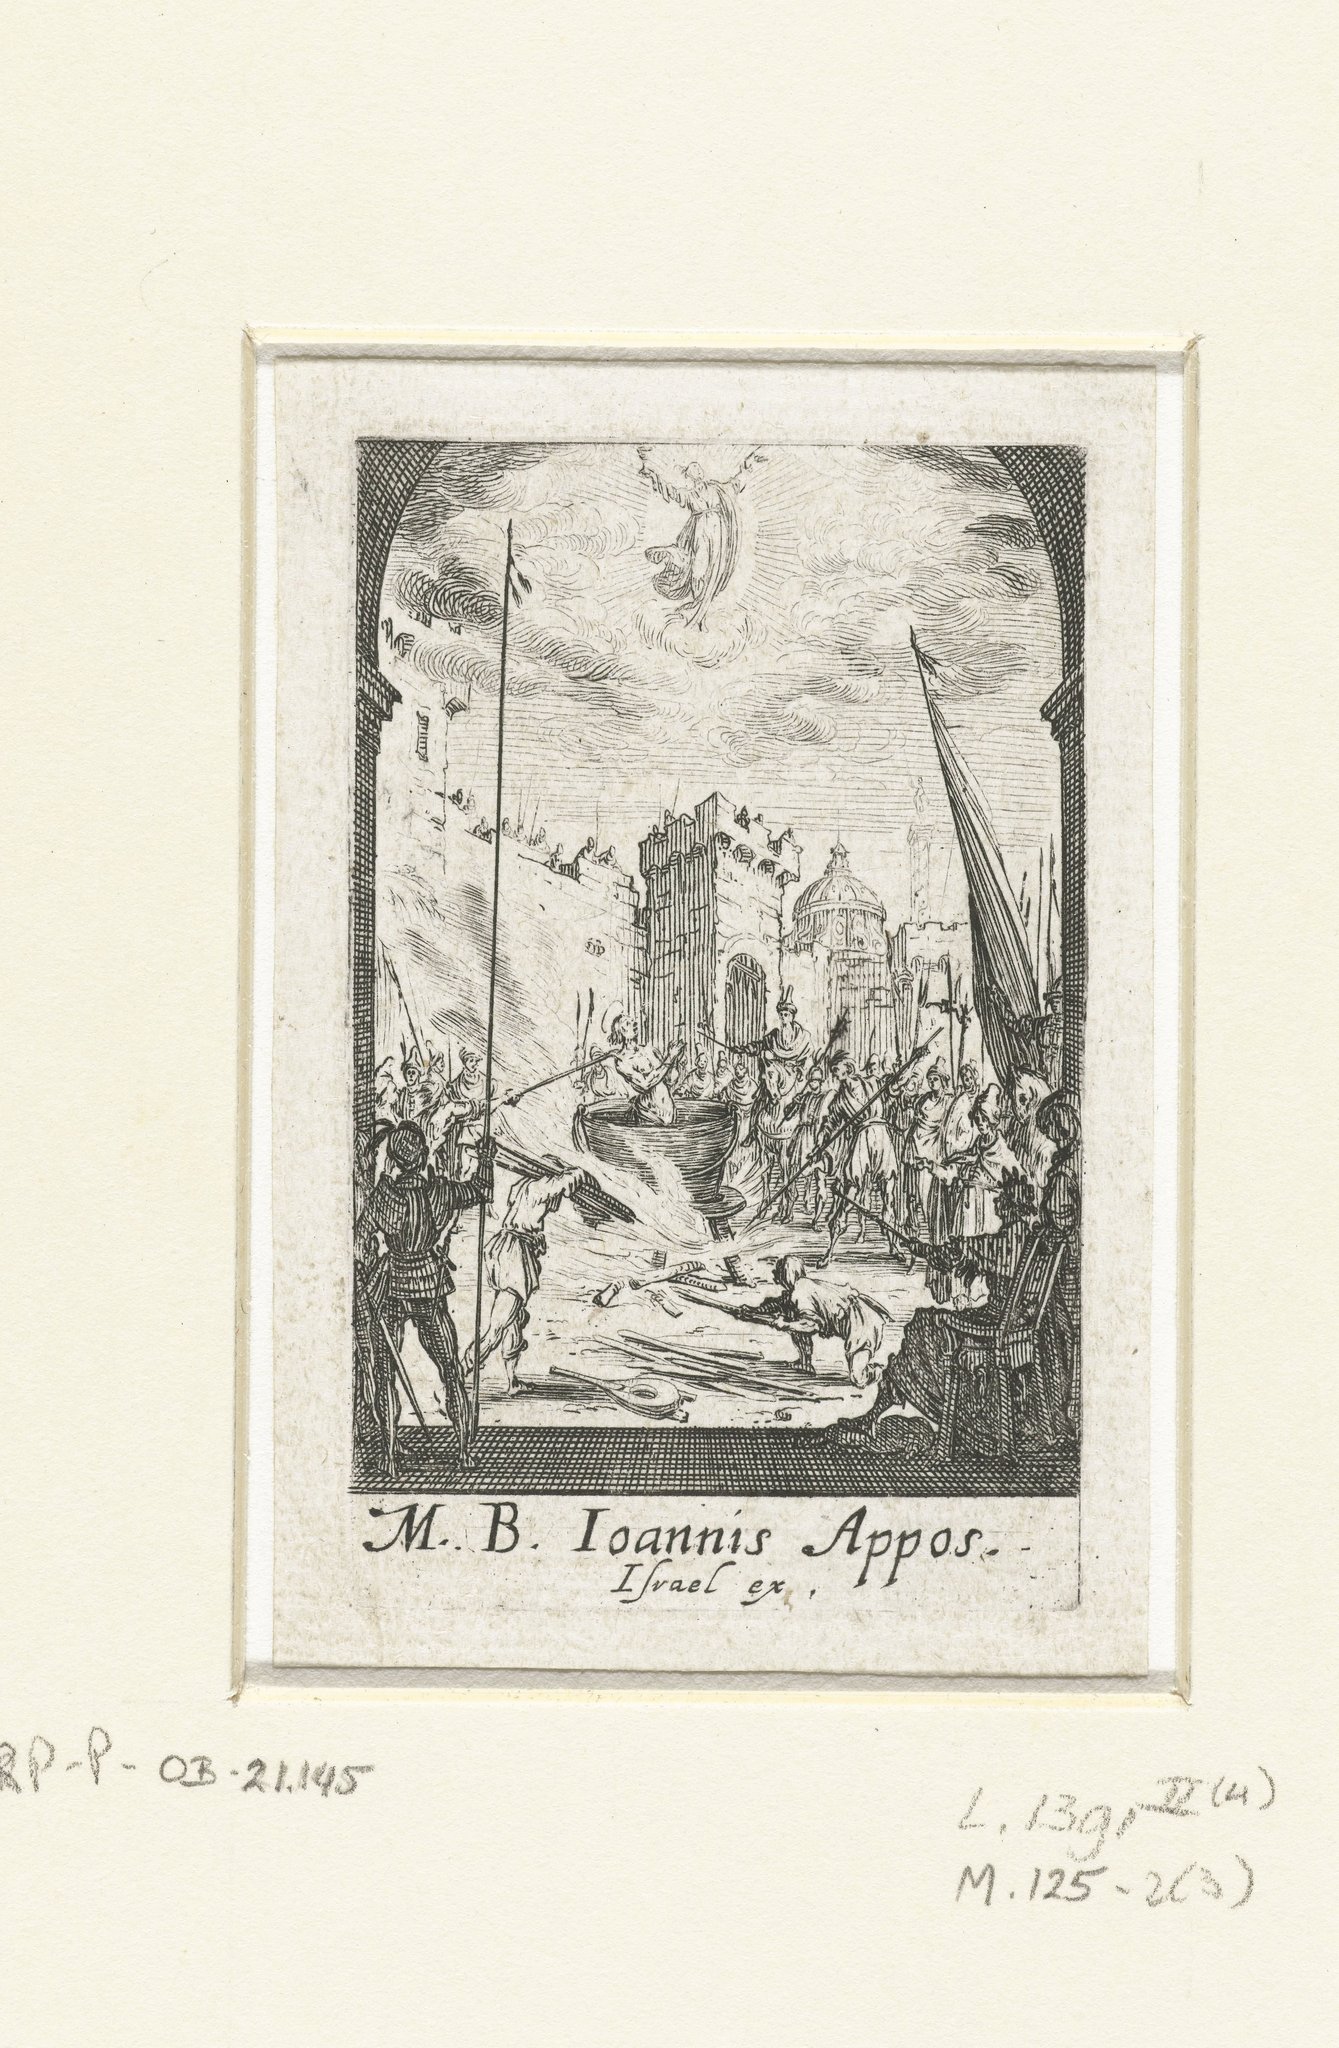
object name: print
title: De kleine apostelen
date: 1632-1634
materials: paper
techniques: etching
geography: nancy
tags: martyrdom of john in front of the porta latina: he is put in a cauldron of boiling oil, but remains unharmed, the apostle john the evangelist; possible attributes: book, cauldron, chalice with snake, eagle, palm, scroll - martyrdom, suffering, misfortune, death of male saint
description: Bij een stadsmuur zit Johannes in een pot met kokende olie. Soldaten staan om hem heen. Boven deze scène is Johannes nogmaals afgebeeld, op een wolk in de hemel, een beker in de hand. Onder de voorstelling een onderschrift in Latijn. Deze prent is onderdeel van een reeks van 16 prenten, bestaande uit een titelblad en 15 voorstellingen van de martelingen die de apostelen hebben ondergaan.